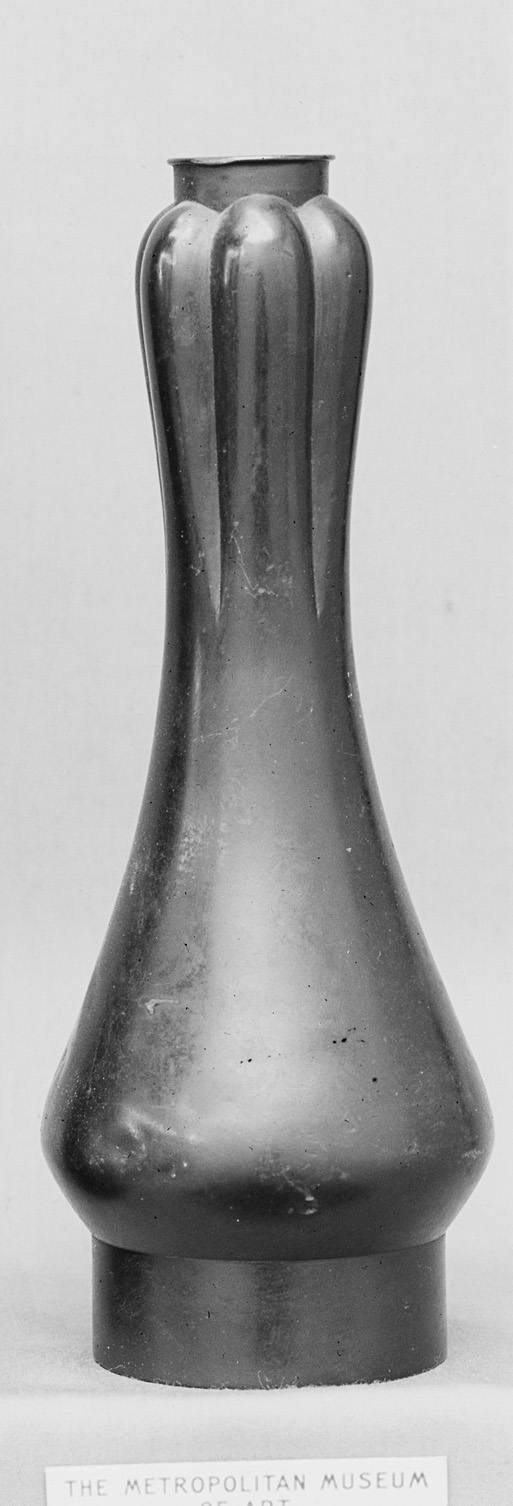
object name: flower vase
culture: japanese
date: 1801-1900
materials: bronze